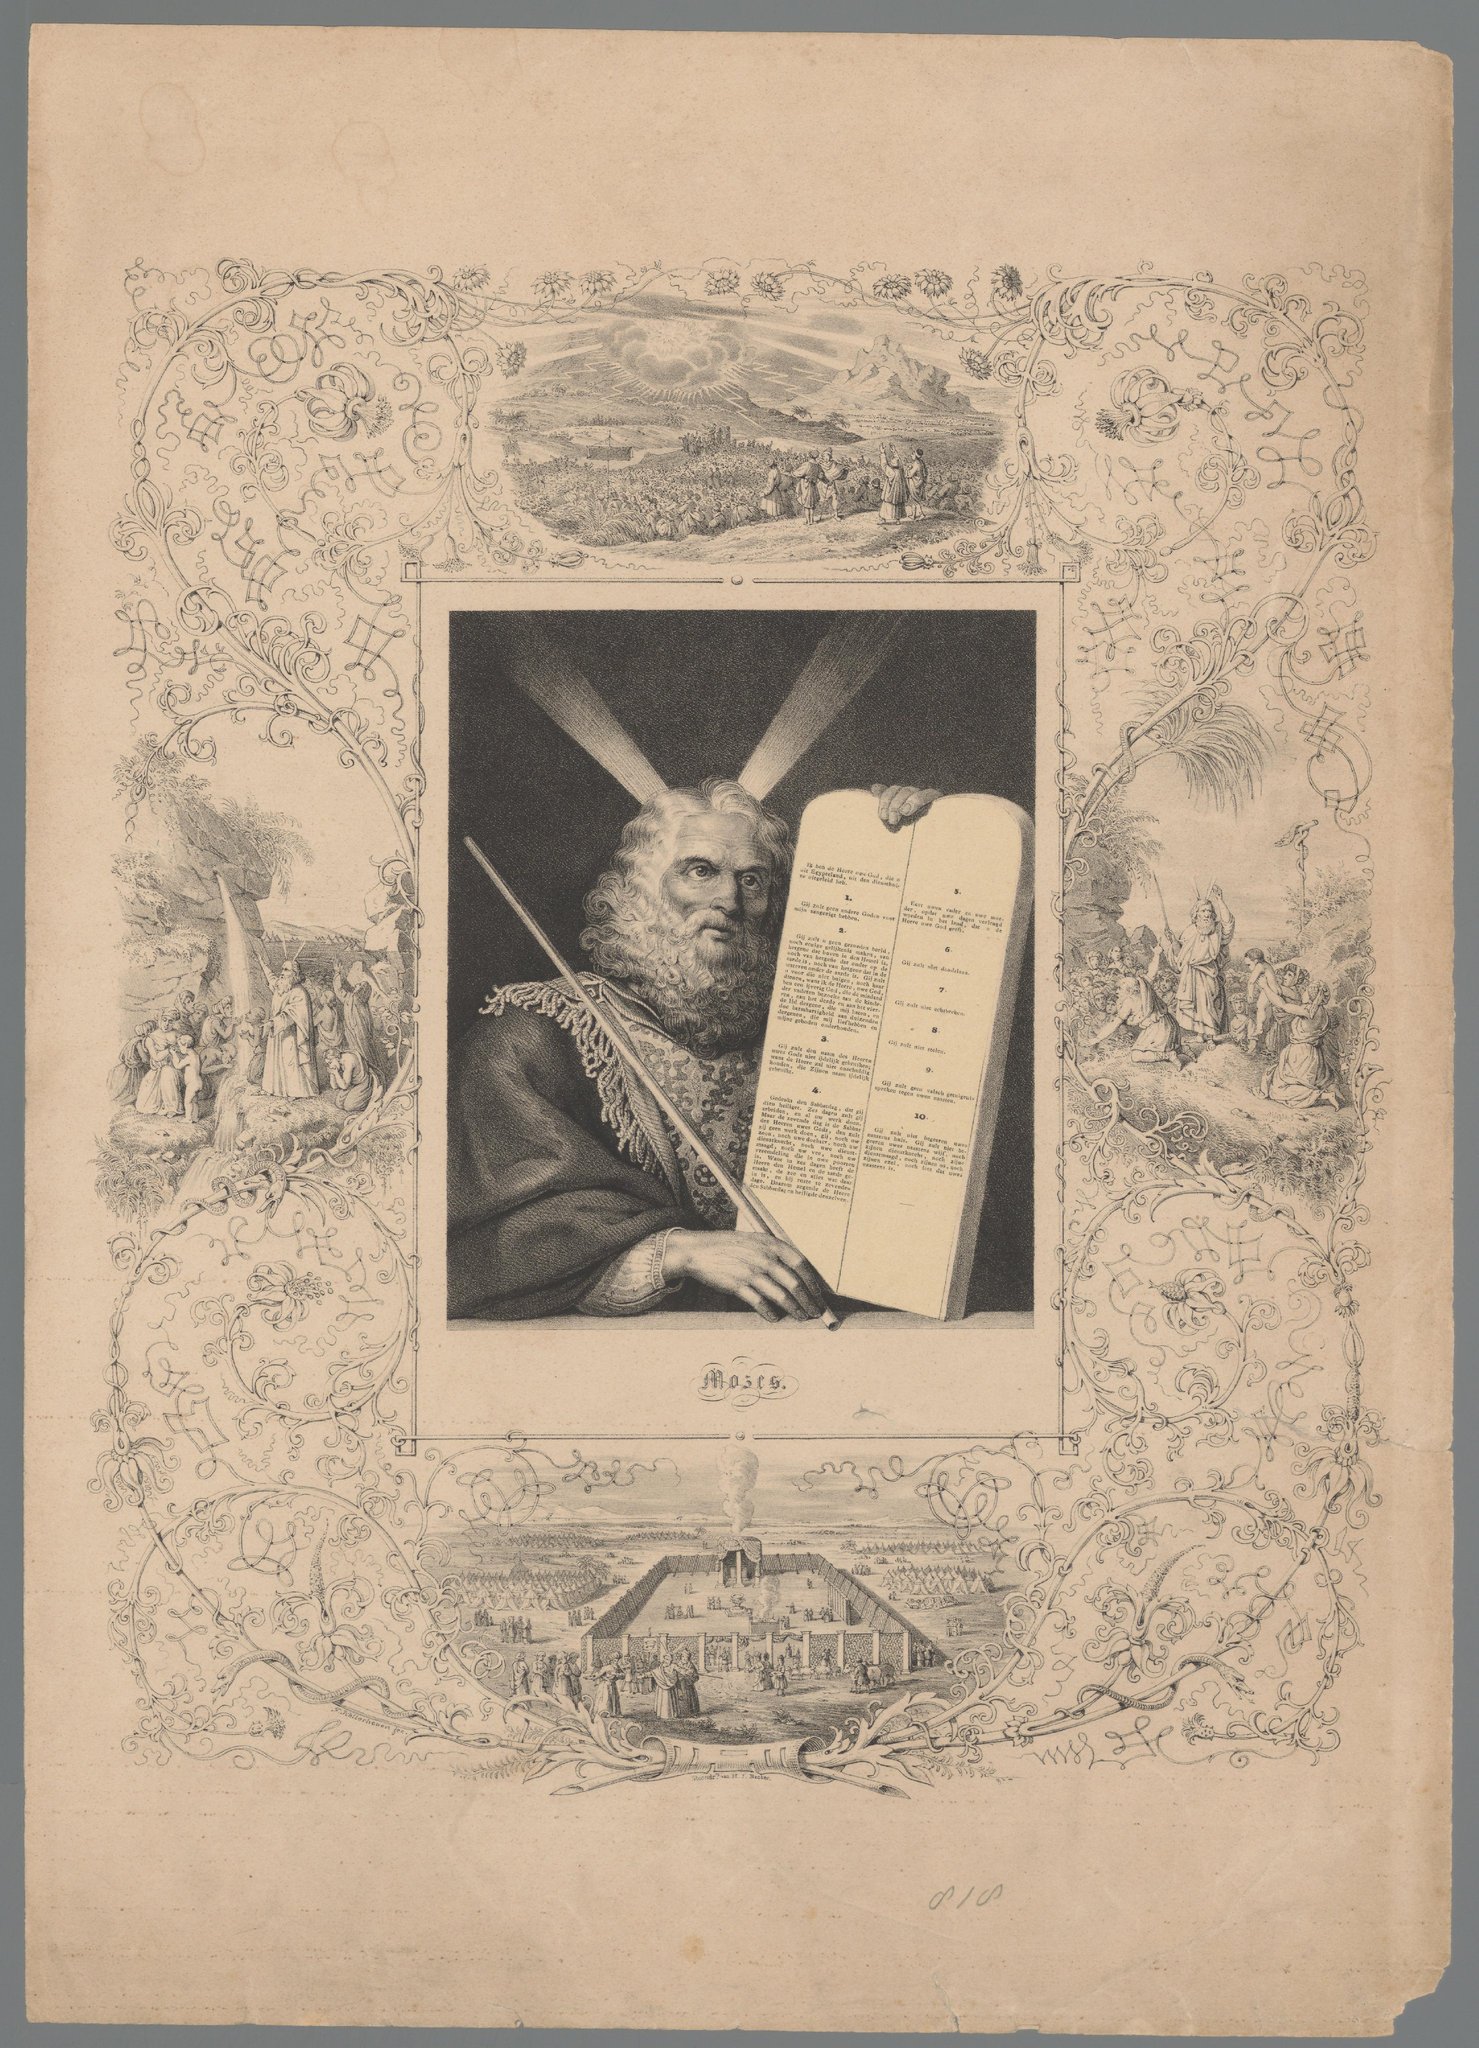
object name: print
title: Mozes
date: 1824-1845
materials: paper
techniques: lithograph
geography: dordrecht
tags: the brazen serpent (numbers 21:4-9), the ten commandments represented together on stone tablets, mount sinai is covered by a thick cloud, thunder and lightning, moses striking water from the rock (exodus 17:1-7; numbers 20:2-13)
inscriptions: collector's mark: Lugt 2228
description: Mozes houdt in zijn hand de stenen tafelen met de tien geboden vast. In het kader zijn vier oudtestamentische voorstellingen weergegeven: Mozes bij de rots, Mozes en de koperen slang, Mozes bij het offeraltaar in het tentenkamp en onweer boven een berglandschap.